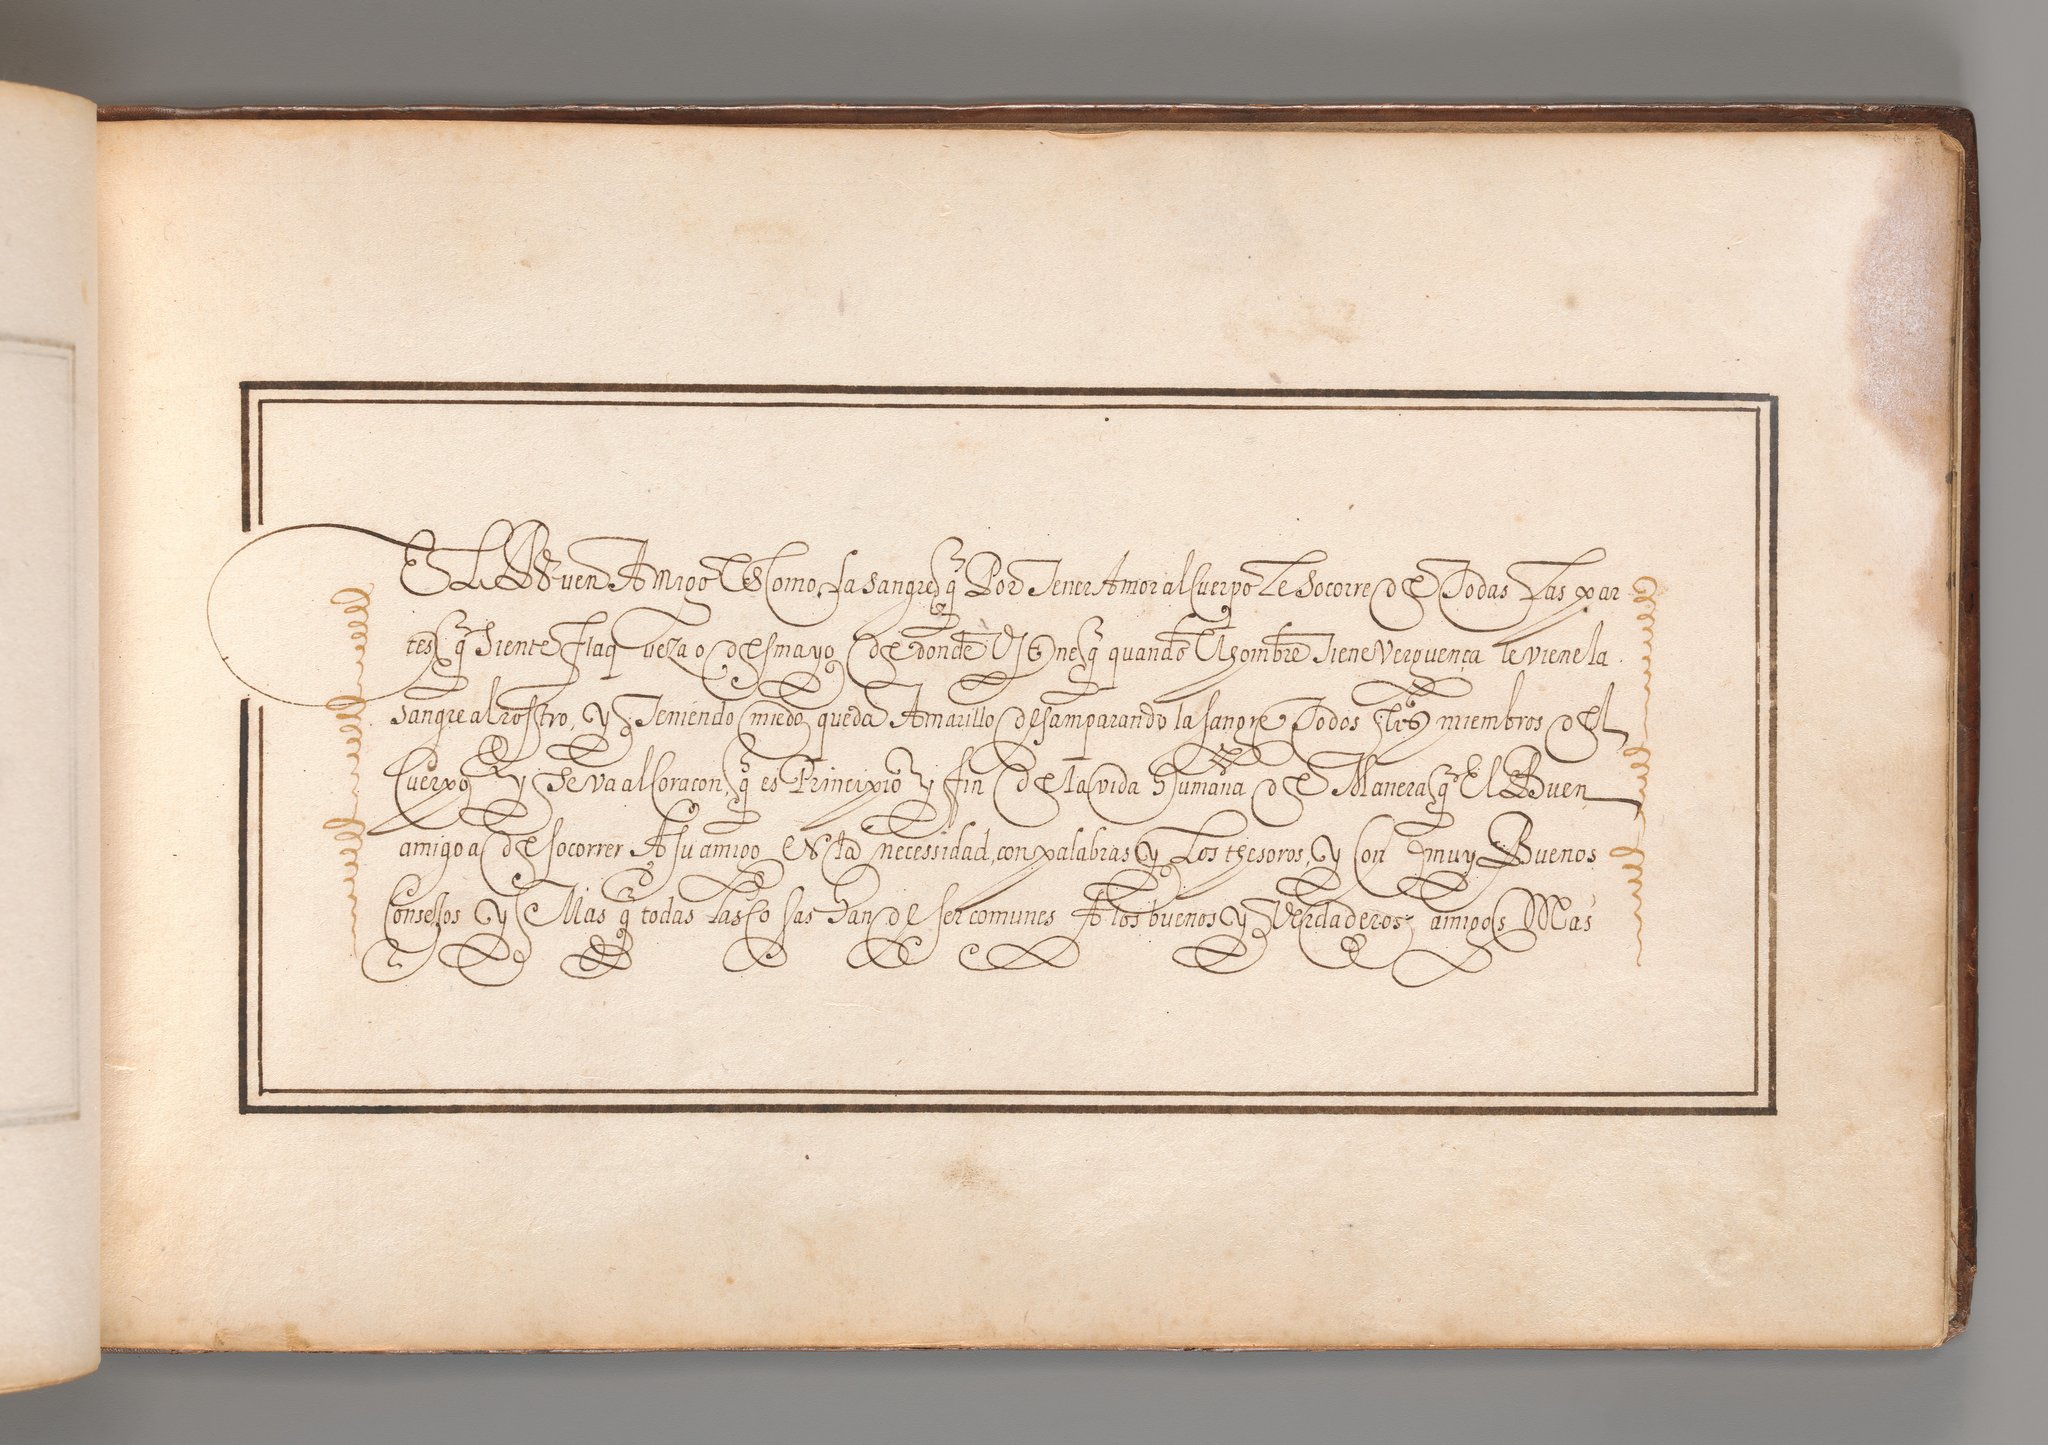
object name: album print ornament architecture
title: Calligraphic Exercise in Spanish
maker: Anonymous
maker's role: artist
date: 1601-1633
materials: ink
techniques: pen